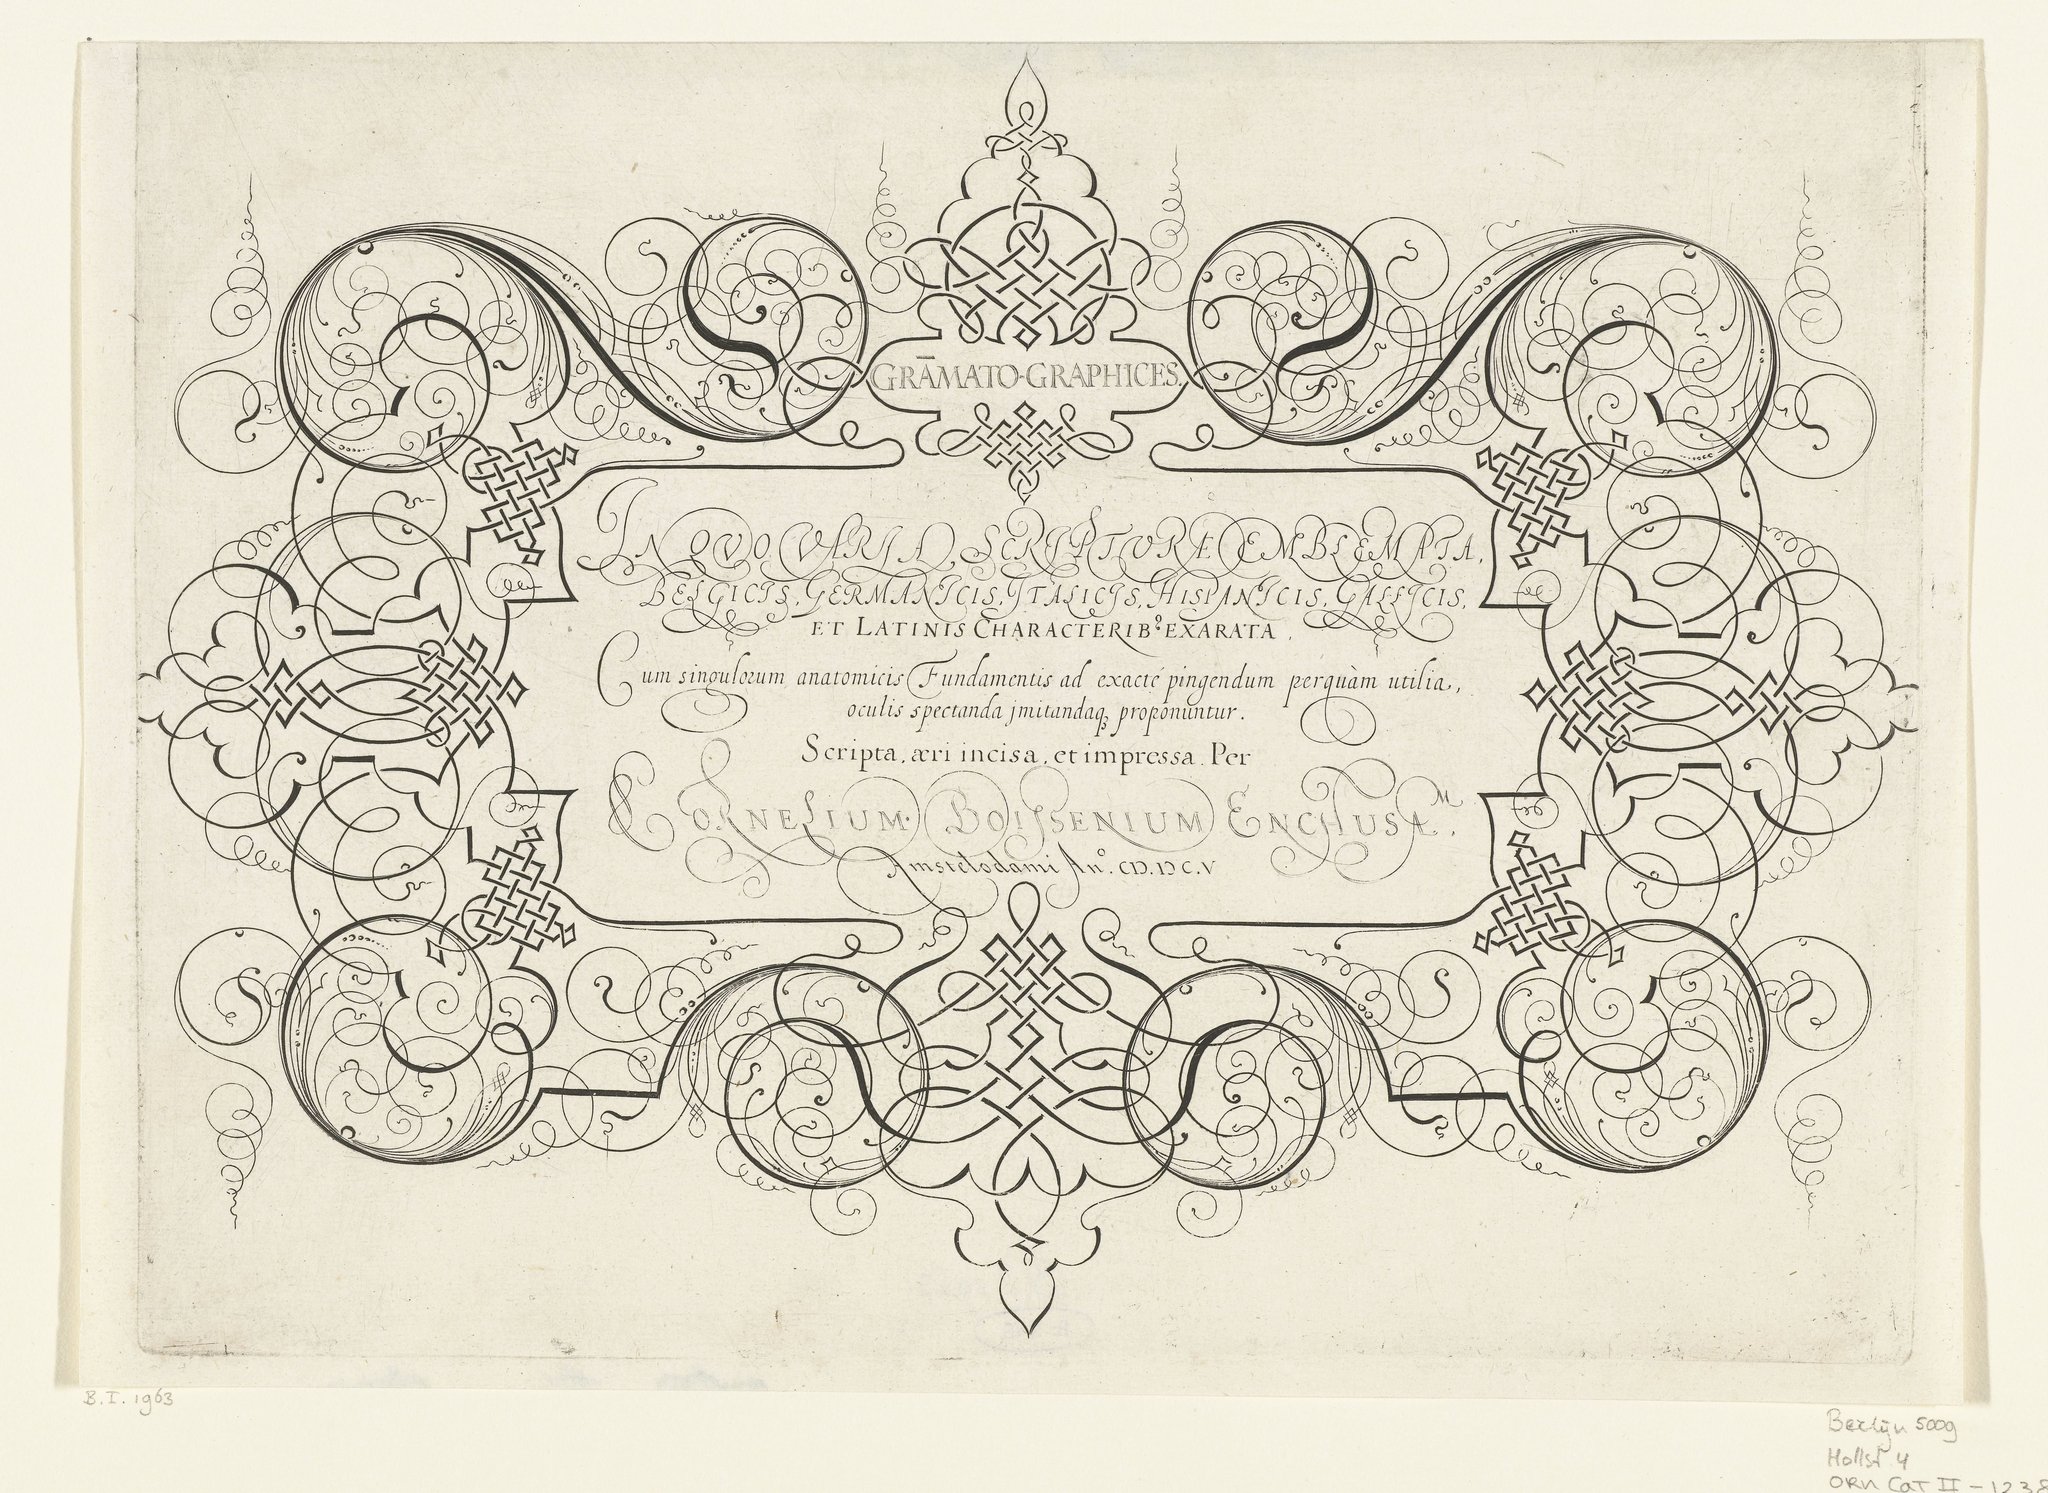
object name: print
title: Grammato-Graphices. In Quo Varia Scripurae Emblemata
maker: cornelis dircksz. boissens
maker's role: draughtsman, print maker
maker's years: 1567-1635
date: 1605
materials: paper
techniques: engraving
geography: amsterdam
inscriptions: date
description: Tekst in rand van gestileerd rolwerk. Uit serie van 41 (?) bladen.